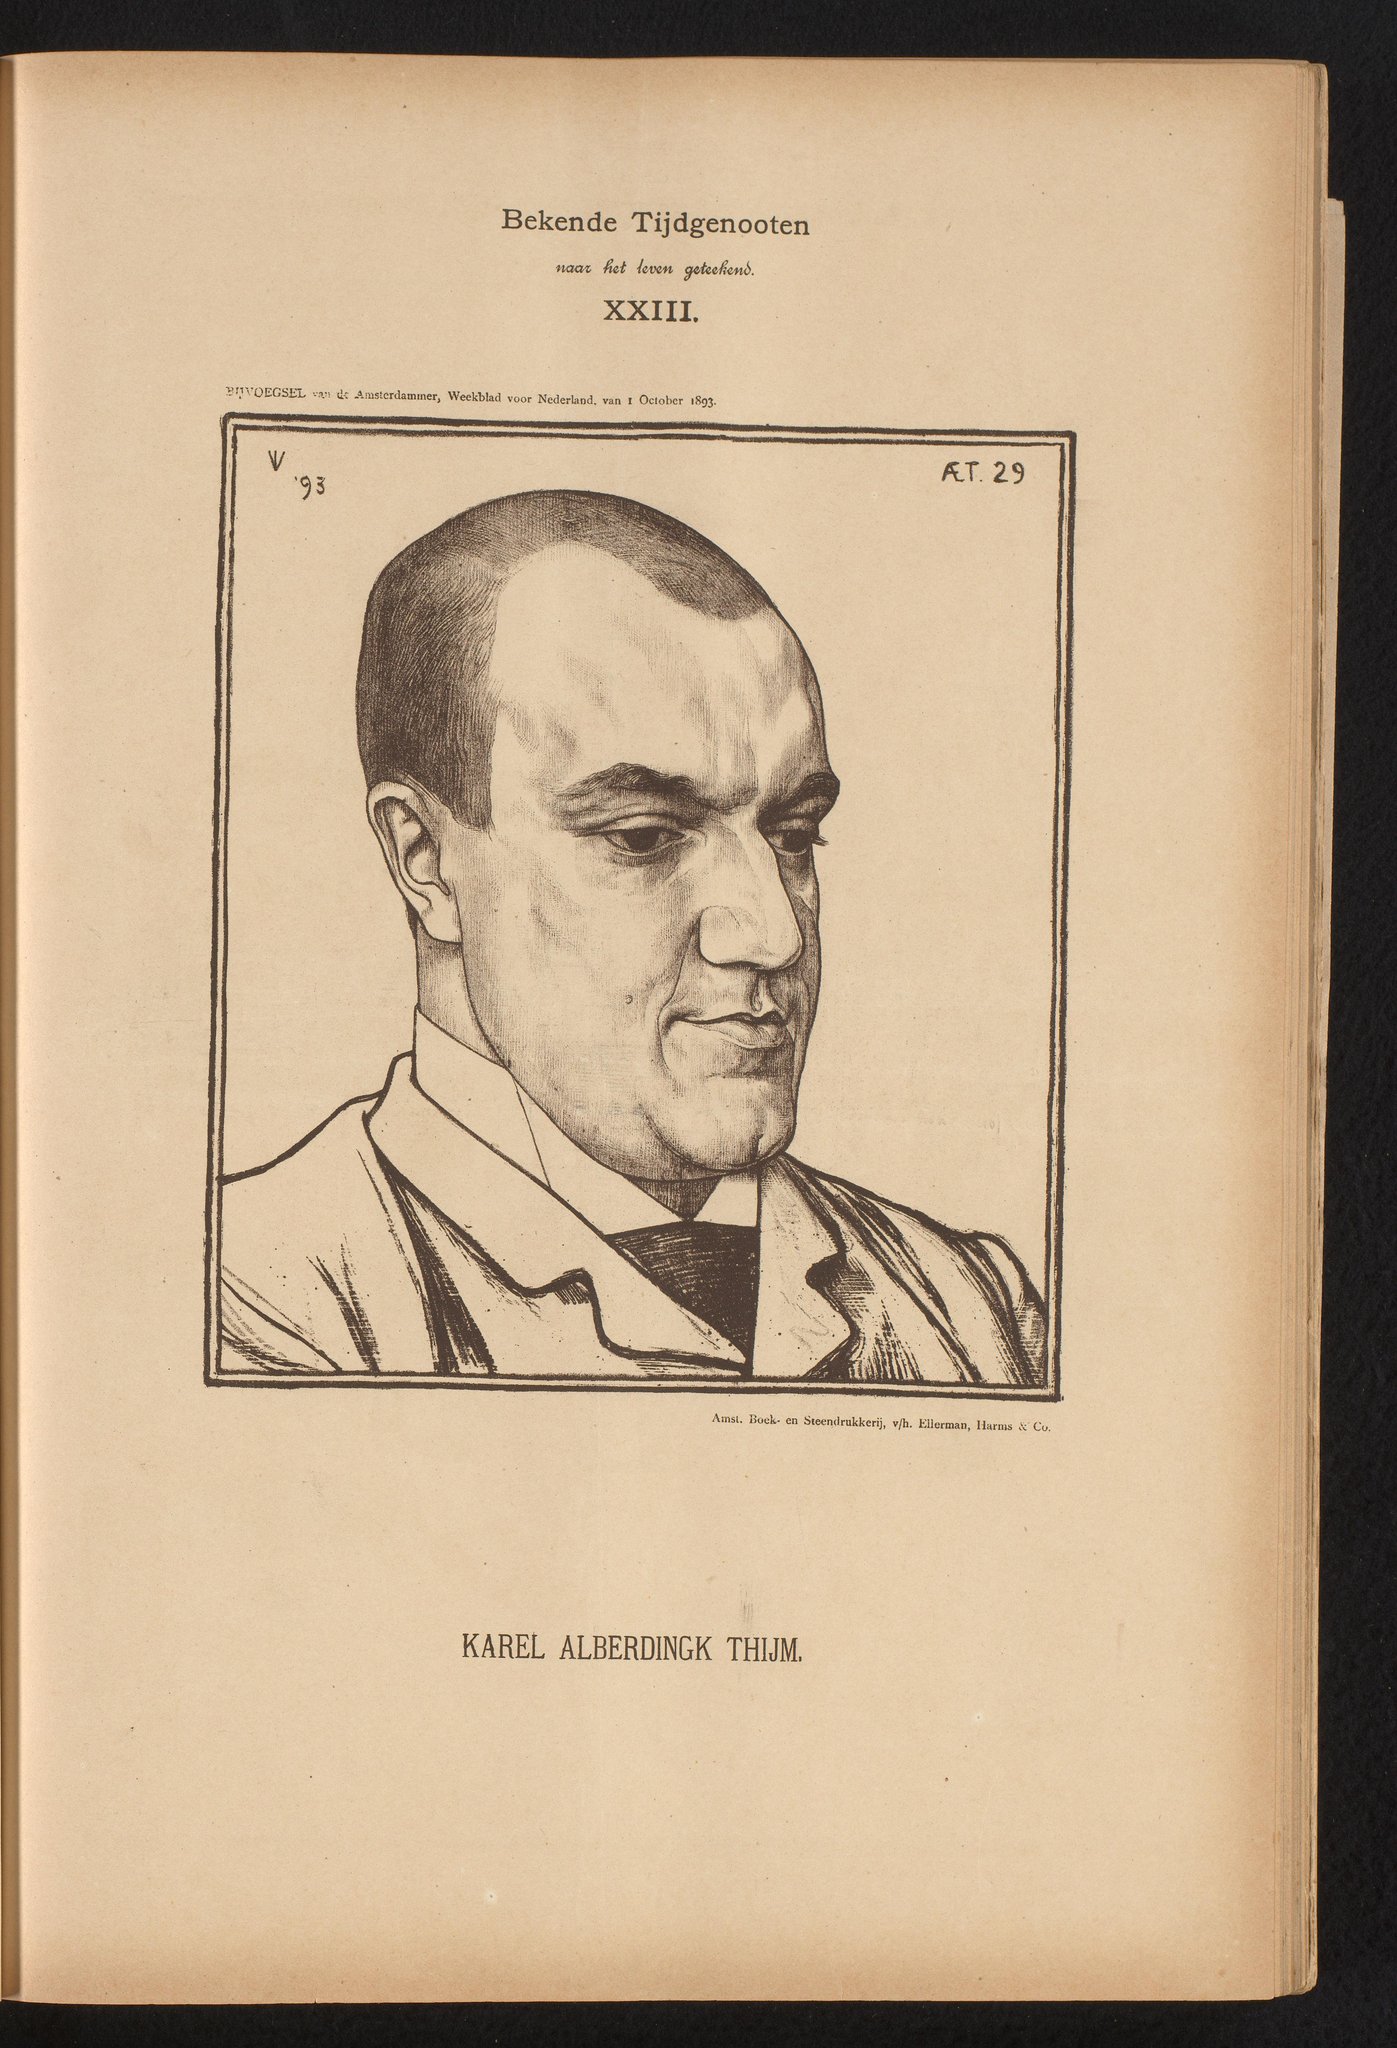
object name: print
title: Bekende Tijdgenooten naar het leven geschetst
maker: jan veth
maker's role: designer, draughtsman, painter, print maker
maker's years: 1864-1925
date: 1893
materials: paper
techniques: lithograph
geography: netherlands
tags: amsterdam, haarlem, karel johan lodewijk alberdingk thijm, writer, poet, author (+ portrait, self-portrait of artist), historical persons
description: Portret van de schrijver Karel Joan Lodewijk Alberdingk Thijm, bekend onder het pseudoniem Lodewijk van Deyssel. In de serie 'Bekende Tijdgenooten', nr. XXIII.